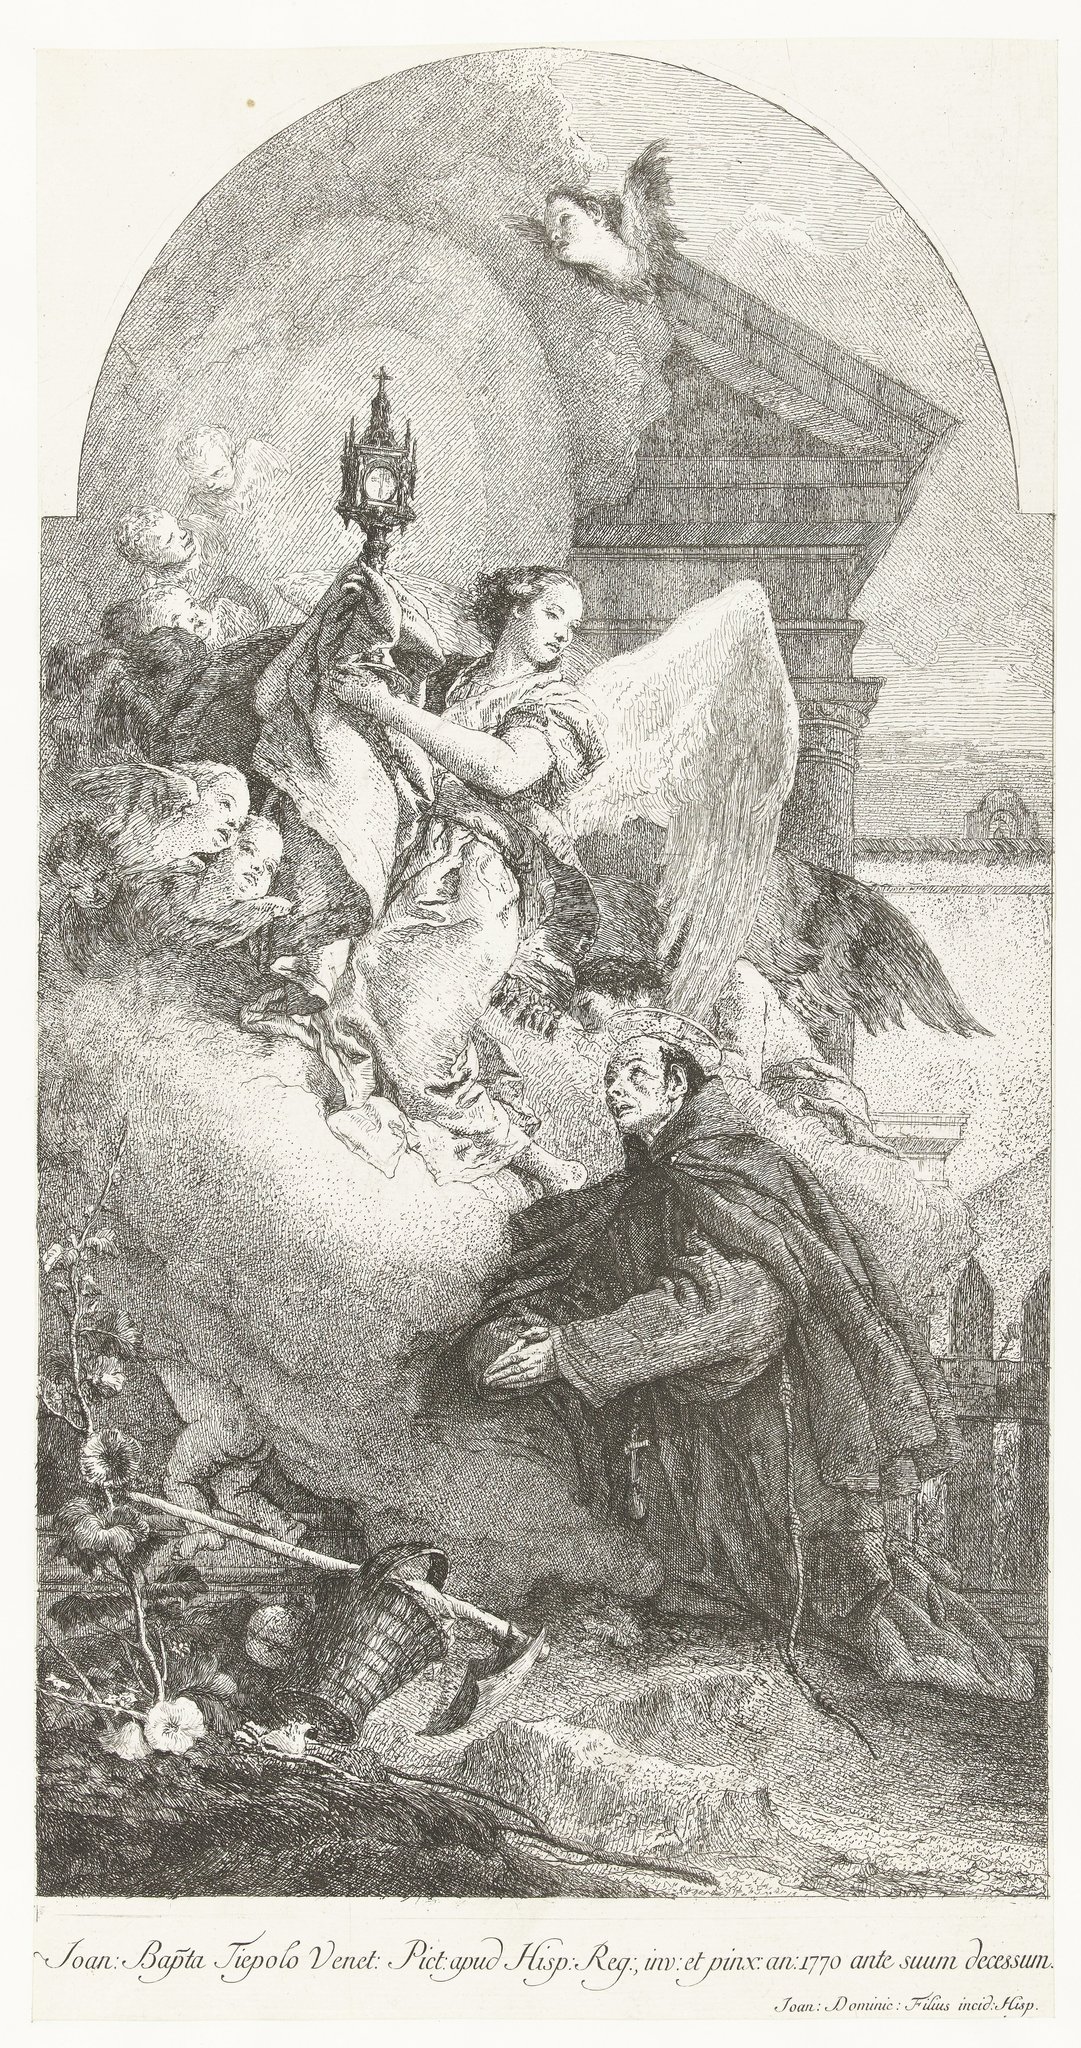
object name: print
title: Heilige Diego knielt in aanbidding voor hostie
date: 1768-1772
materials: paper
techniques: engraving, etching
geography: venice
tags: saints, angels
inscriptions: collector's mark: Lugt 2228, collector's mark: Lugt 2760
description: Prent naar schilderij van Giovanni Battista Tiepolo. Dit is de enige prent waarop een in Spanje vervaardigd werk van zijn vader terugkomt. Het is een staat voor toevoeging van nummer 28 zoals beschreven bij De Vesme 1906 en Rizzi 1971.